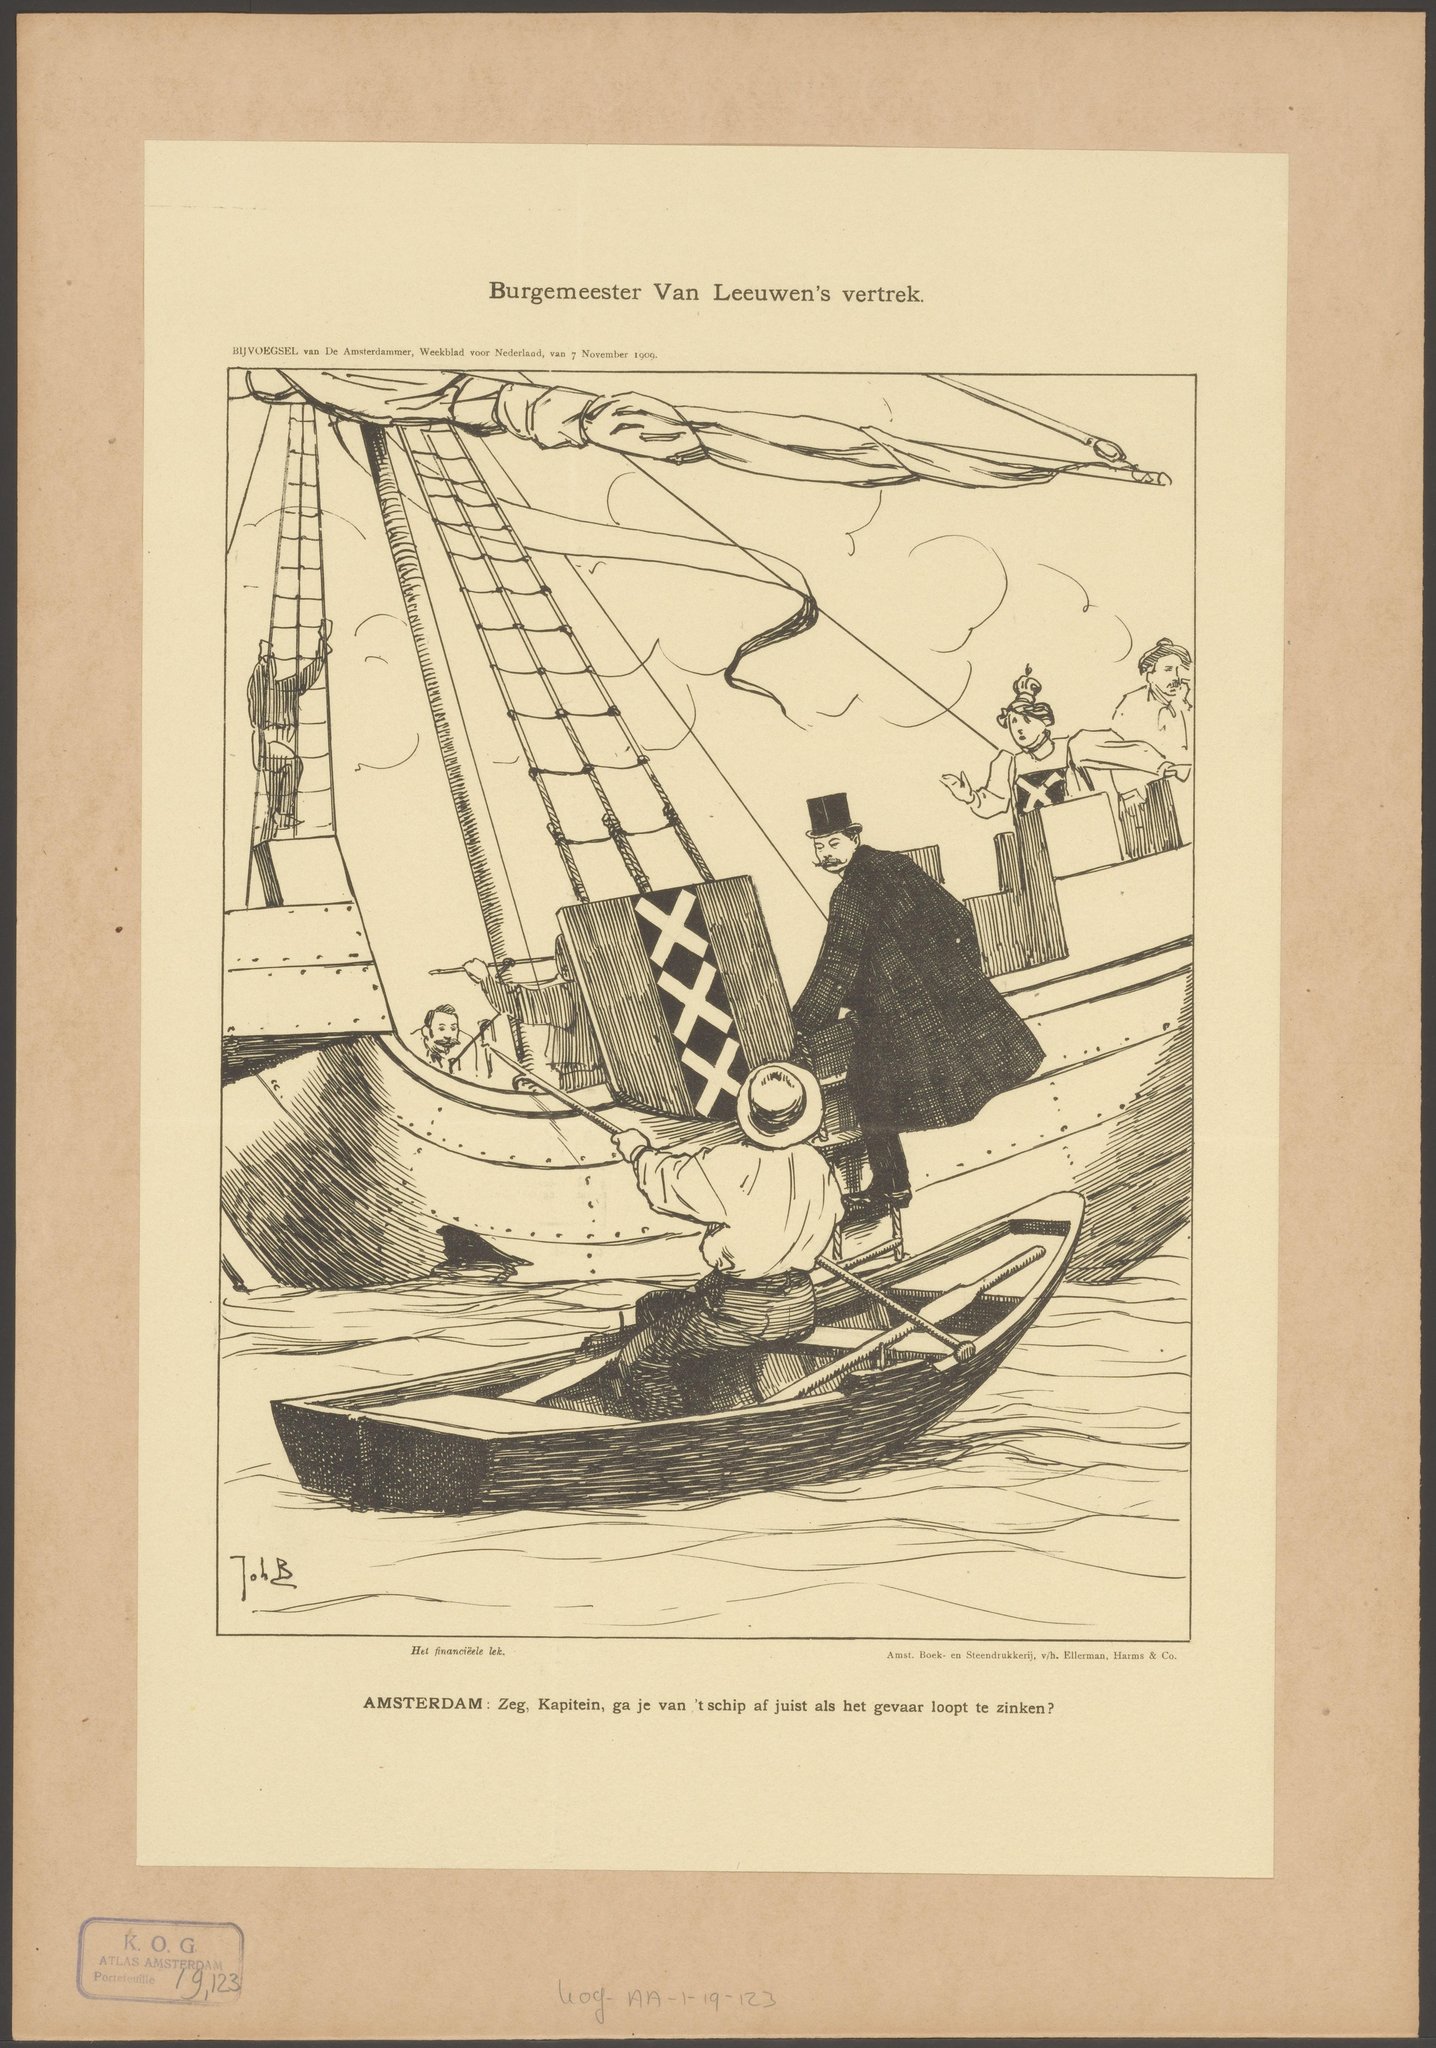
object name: cartoon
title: Spotprent op het vertrek van burgemeester Wilhelmus Frederik van Leeuwen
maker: johan braakensiek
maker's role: draughtsman, print maker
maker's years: 1858-1940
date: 1909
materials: paper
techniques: letterpress printing, line block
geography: amsterdam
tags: mayor, burgomaster, political caricatures and satires, amsterdam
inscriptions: collector's mark: ‘19,123’ Lugt 1641b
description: Onderwerpsrubriek binnen de Atlas Amsterdam: Herinneringen aan regeringsleden en hunne huisgezinnen [na 1800]. Burgemeester Van Leeuwen verlaat het koggeschip Amsterdam en stapt over in een sloep, tot ontsteltenis van de Amsterdamse Maagd.